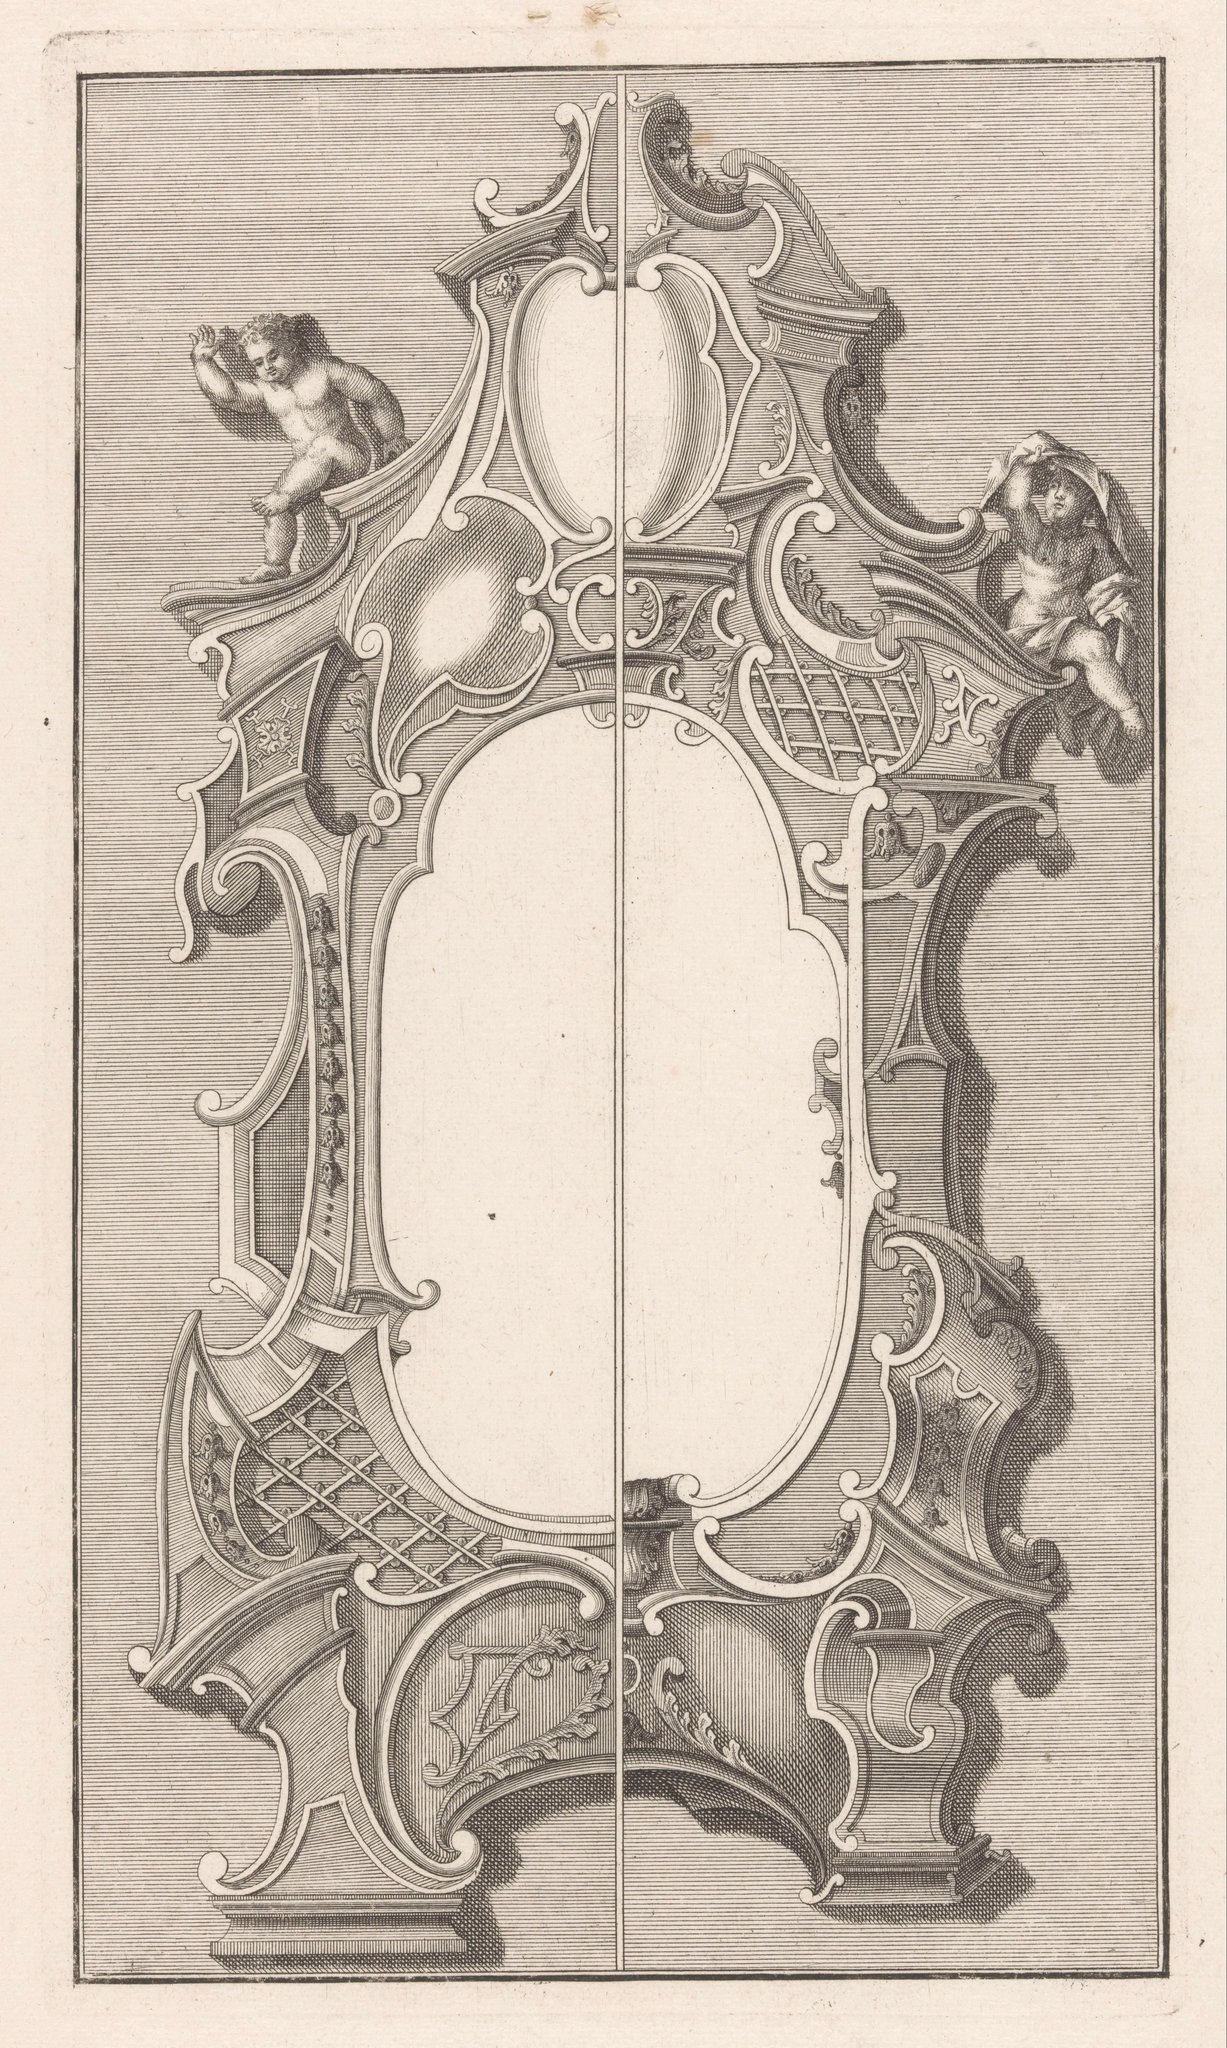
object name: ornament print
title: Cartouche met twee putti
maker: Anonymous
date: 1700-1799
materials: paper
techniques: engraving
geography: germany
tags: ornament ~ cartouche, cupids: 'amores', 'amoretti', 'putti'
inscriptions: collector's mark: Lugt 2228, collector's mark: Lugt 2760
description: Een grote geornamenteerde cartouche met twee putti, rechts met doek.